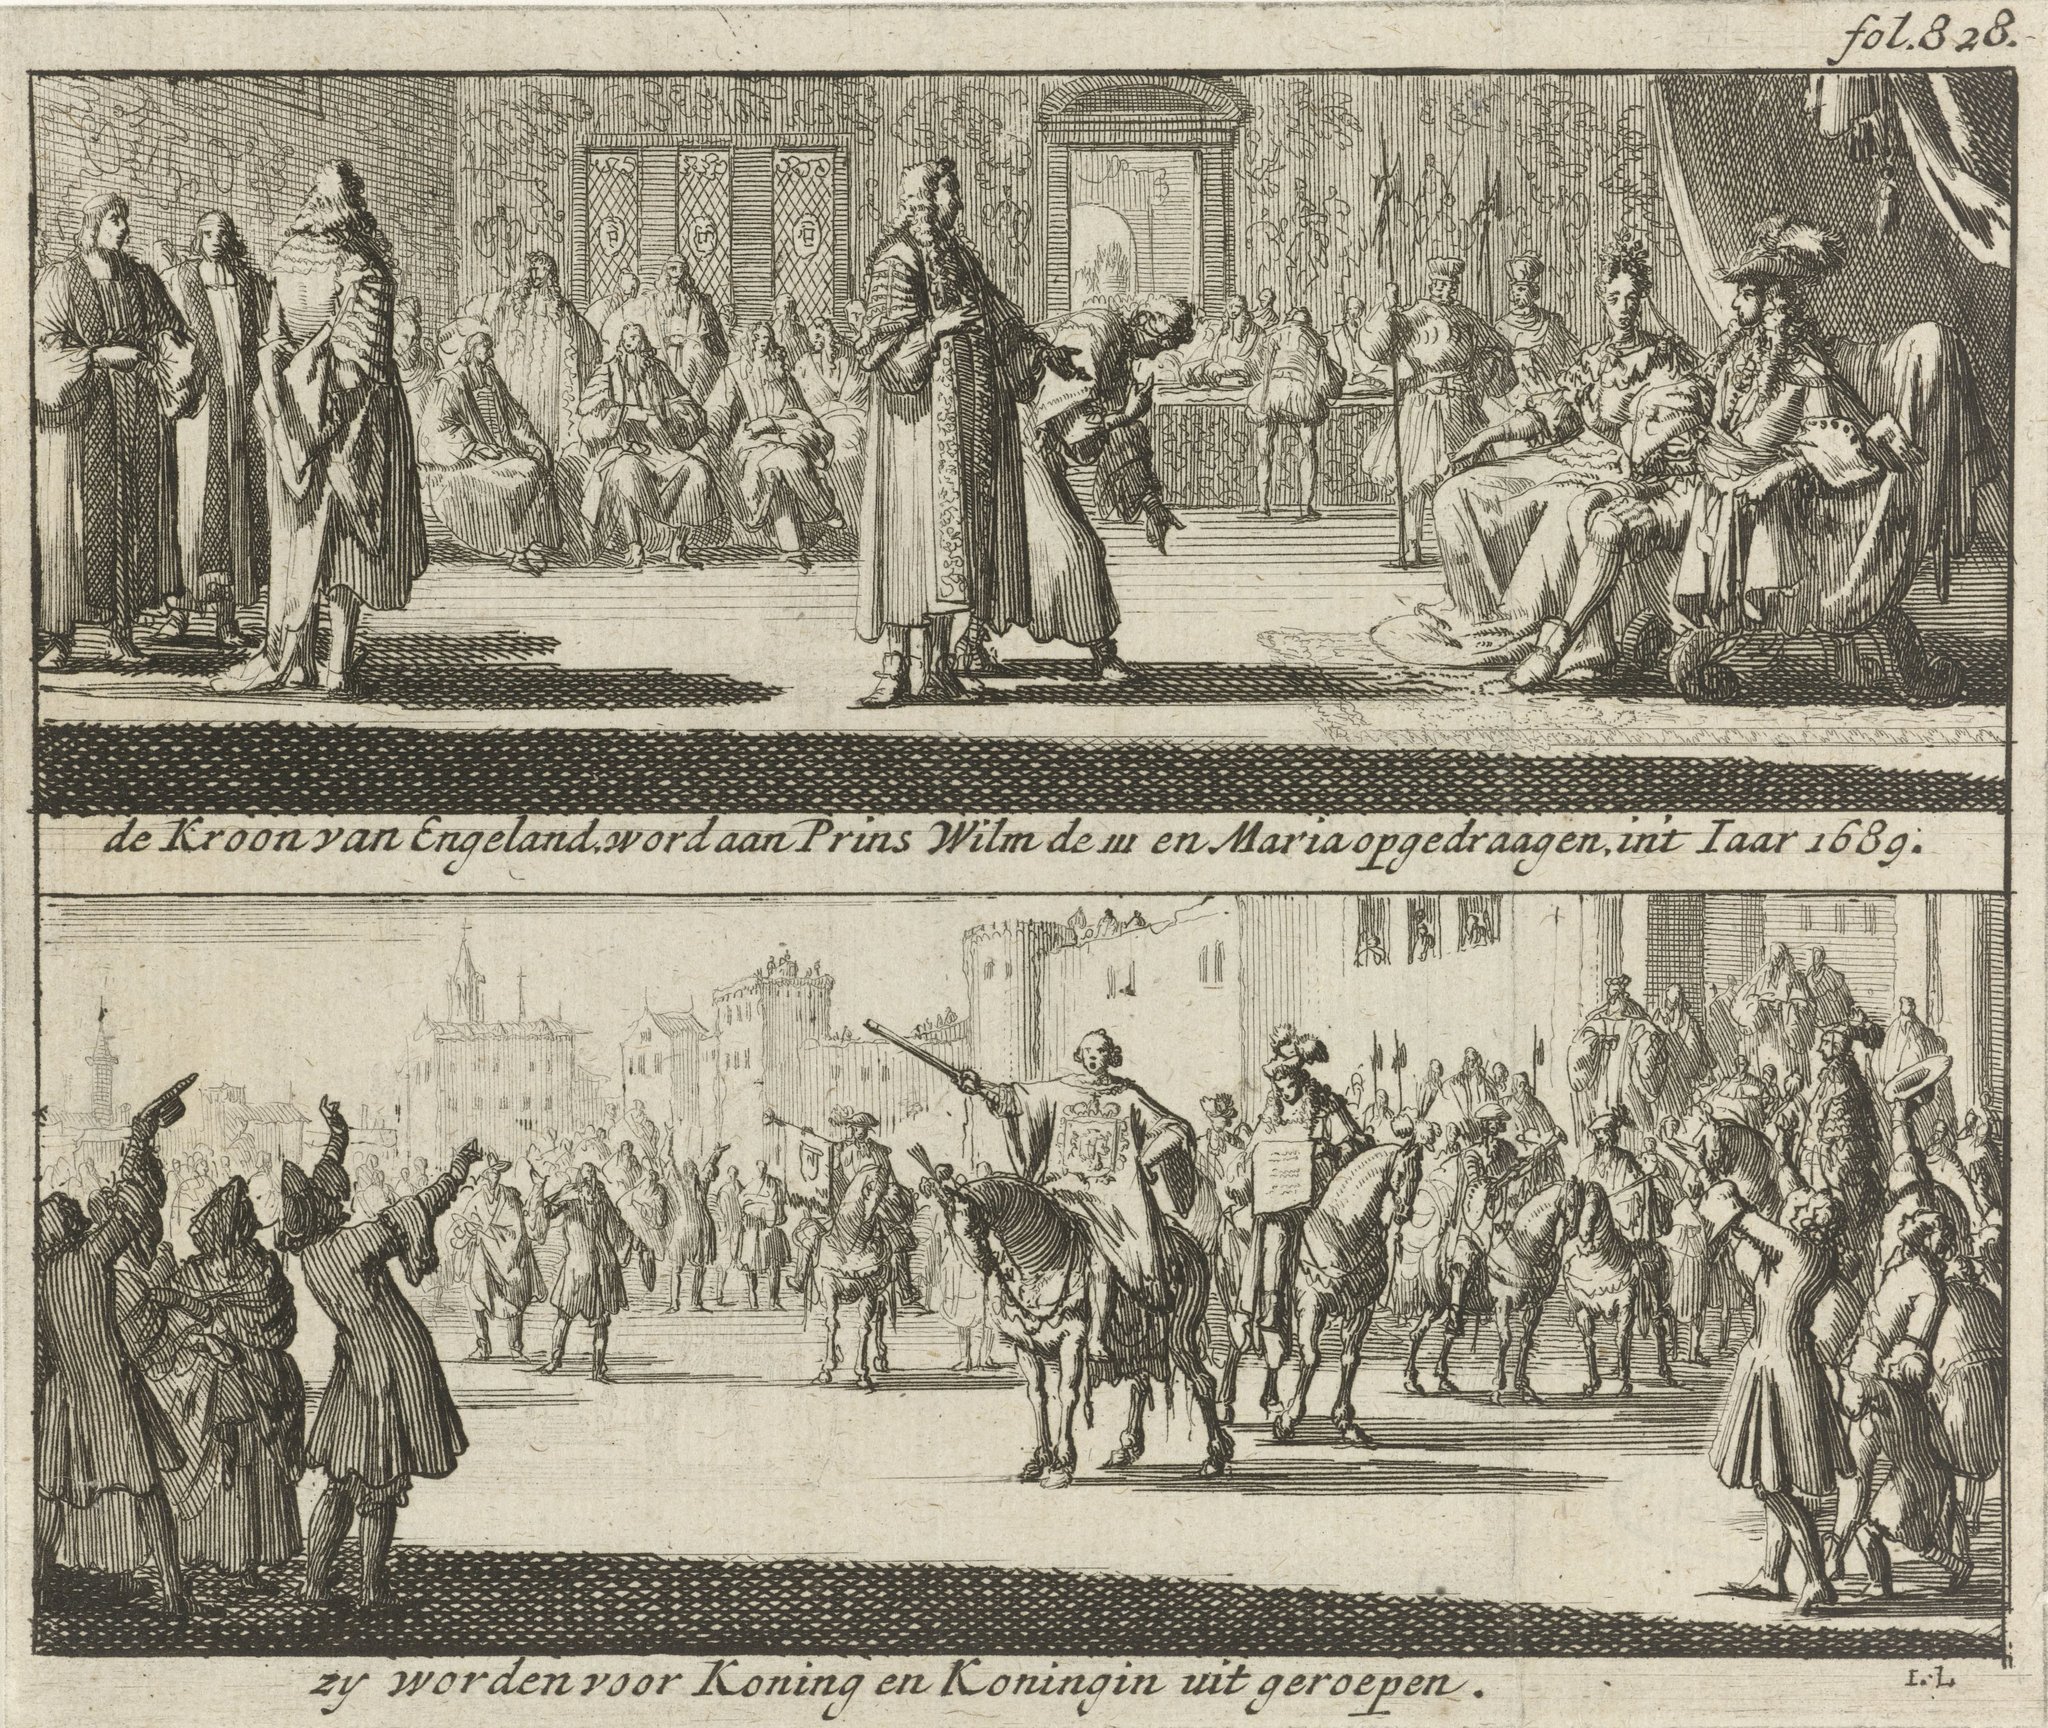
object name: book illustration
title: Willem en Maria uitgeroepen tot koning en koningin van Engeland, 1689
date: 1689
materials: paper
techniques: etching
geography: amsterdam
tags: william iii (prince of orange and king of england, scotland, and ireland), maria ii stuart (koningin van engeland, schotland en ierland), crier (~ proclamation of laws), oral spreading of news, town crier, london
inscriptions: collector's mark: Lugt 2228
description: Illustratie uit: Pers, Dirck Pietersz. Romeynschen adelaer, waer in de loffelĳcke en lasterlĳcke daden der Romeynsche koningen, en keyseren, verhandelt werden, 3 delen. Utrecht: Jurriaen van Poolsum, 1689, fol. 828. Deze prent is ook genummerd FMH 2696 als illustratie voor: Lambert van den Bosch, Het leven en bedryf van Willem de Darde, Jan Claesz ten Hoorn, Amsterdam 1694, 4 delen.